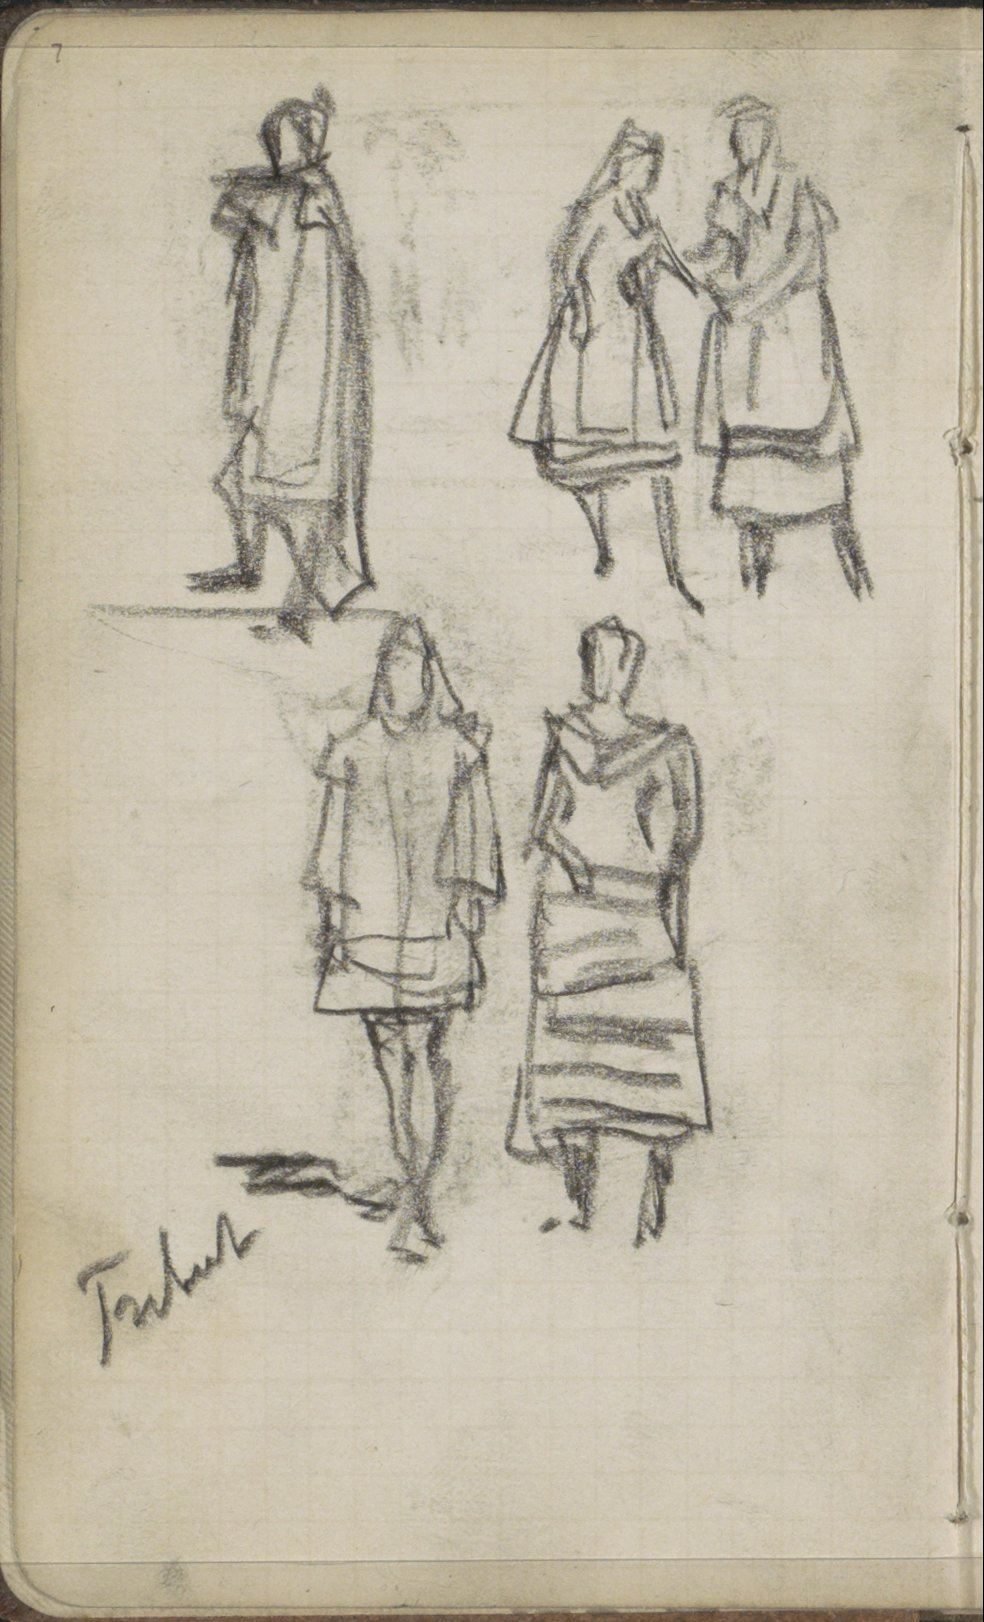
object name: sketchbook leaf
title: Figuren in historisch kostuum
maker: marius bauer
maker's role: draughtsman, print maker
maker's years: 1867-1932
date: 1879-1885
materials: chalk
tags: standing figure, adult woman, adult man, historical costume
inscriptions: annotation: ‘Tribut’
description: Mogelijk kostuums voor een theaterstuk. Pagina 7 uit een schetsboek met 58 bladen.